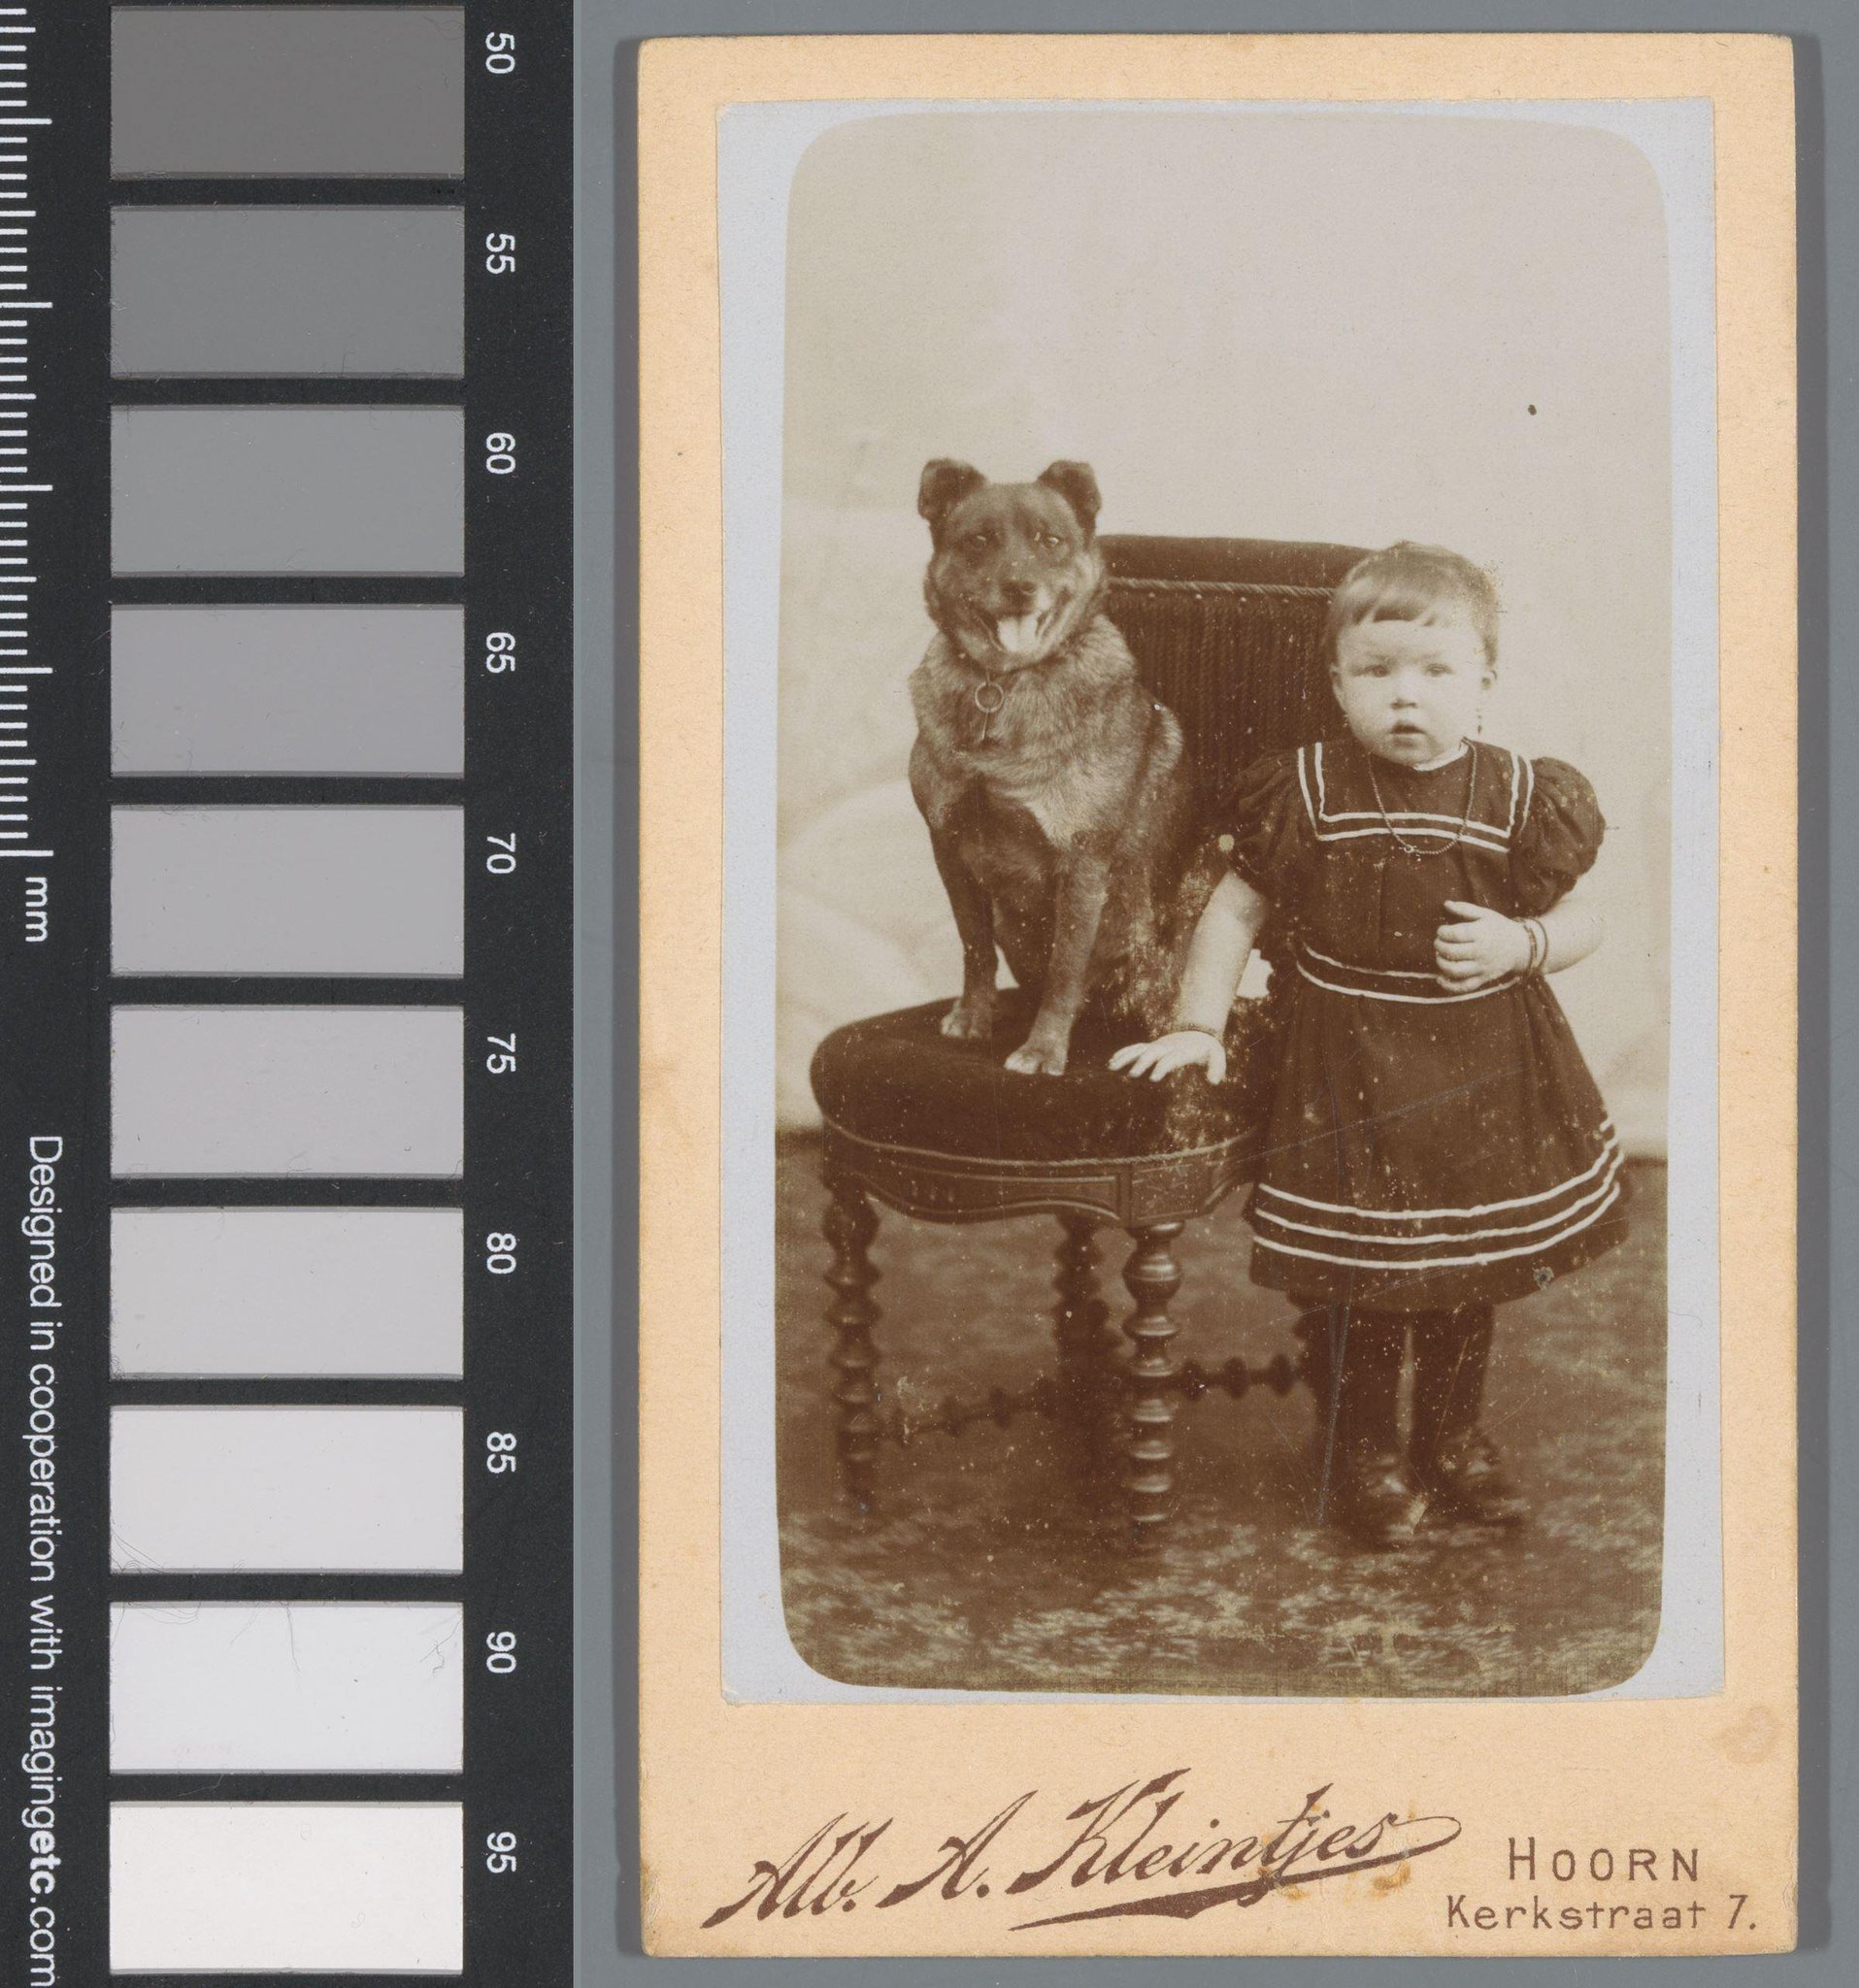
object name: photograph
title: Portret van een onbekend meisje met een hond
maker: albert a. kleintjes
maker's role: fotograaf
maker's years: 1854-1942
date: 1883-1913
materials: paper, cardboard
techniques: collodion silver print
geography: hoorn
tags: toddler, anonymous historical person portrayed, dog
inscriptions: address: ‘Hoorn/ Kerkstraat,/ 4e huis v.d. Kaasmarkt.’, inscription: ‘Nabestellingen en Vergrootingen van deze en andere/ Portretten kunnen ten allen tijde geleverd worden.’